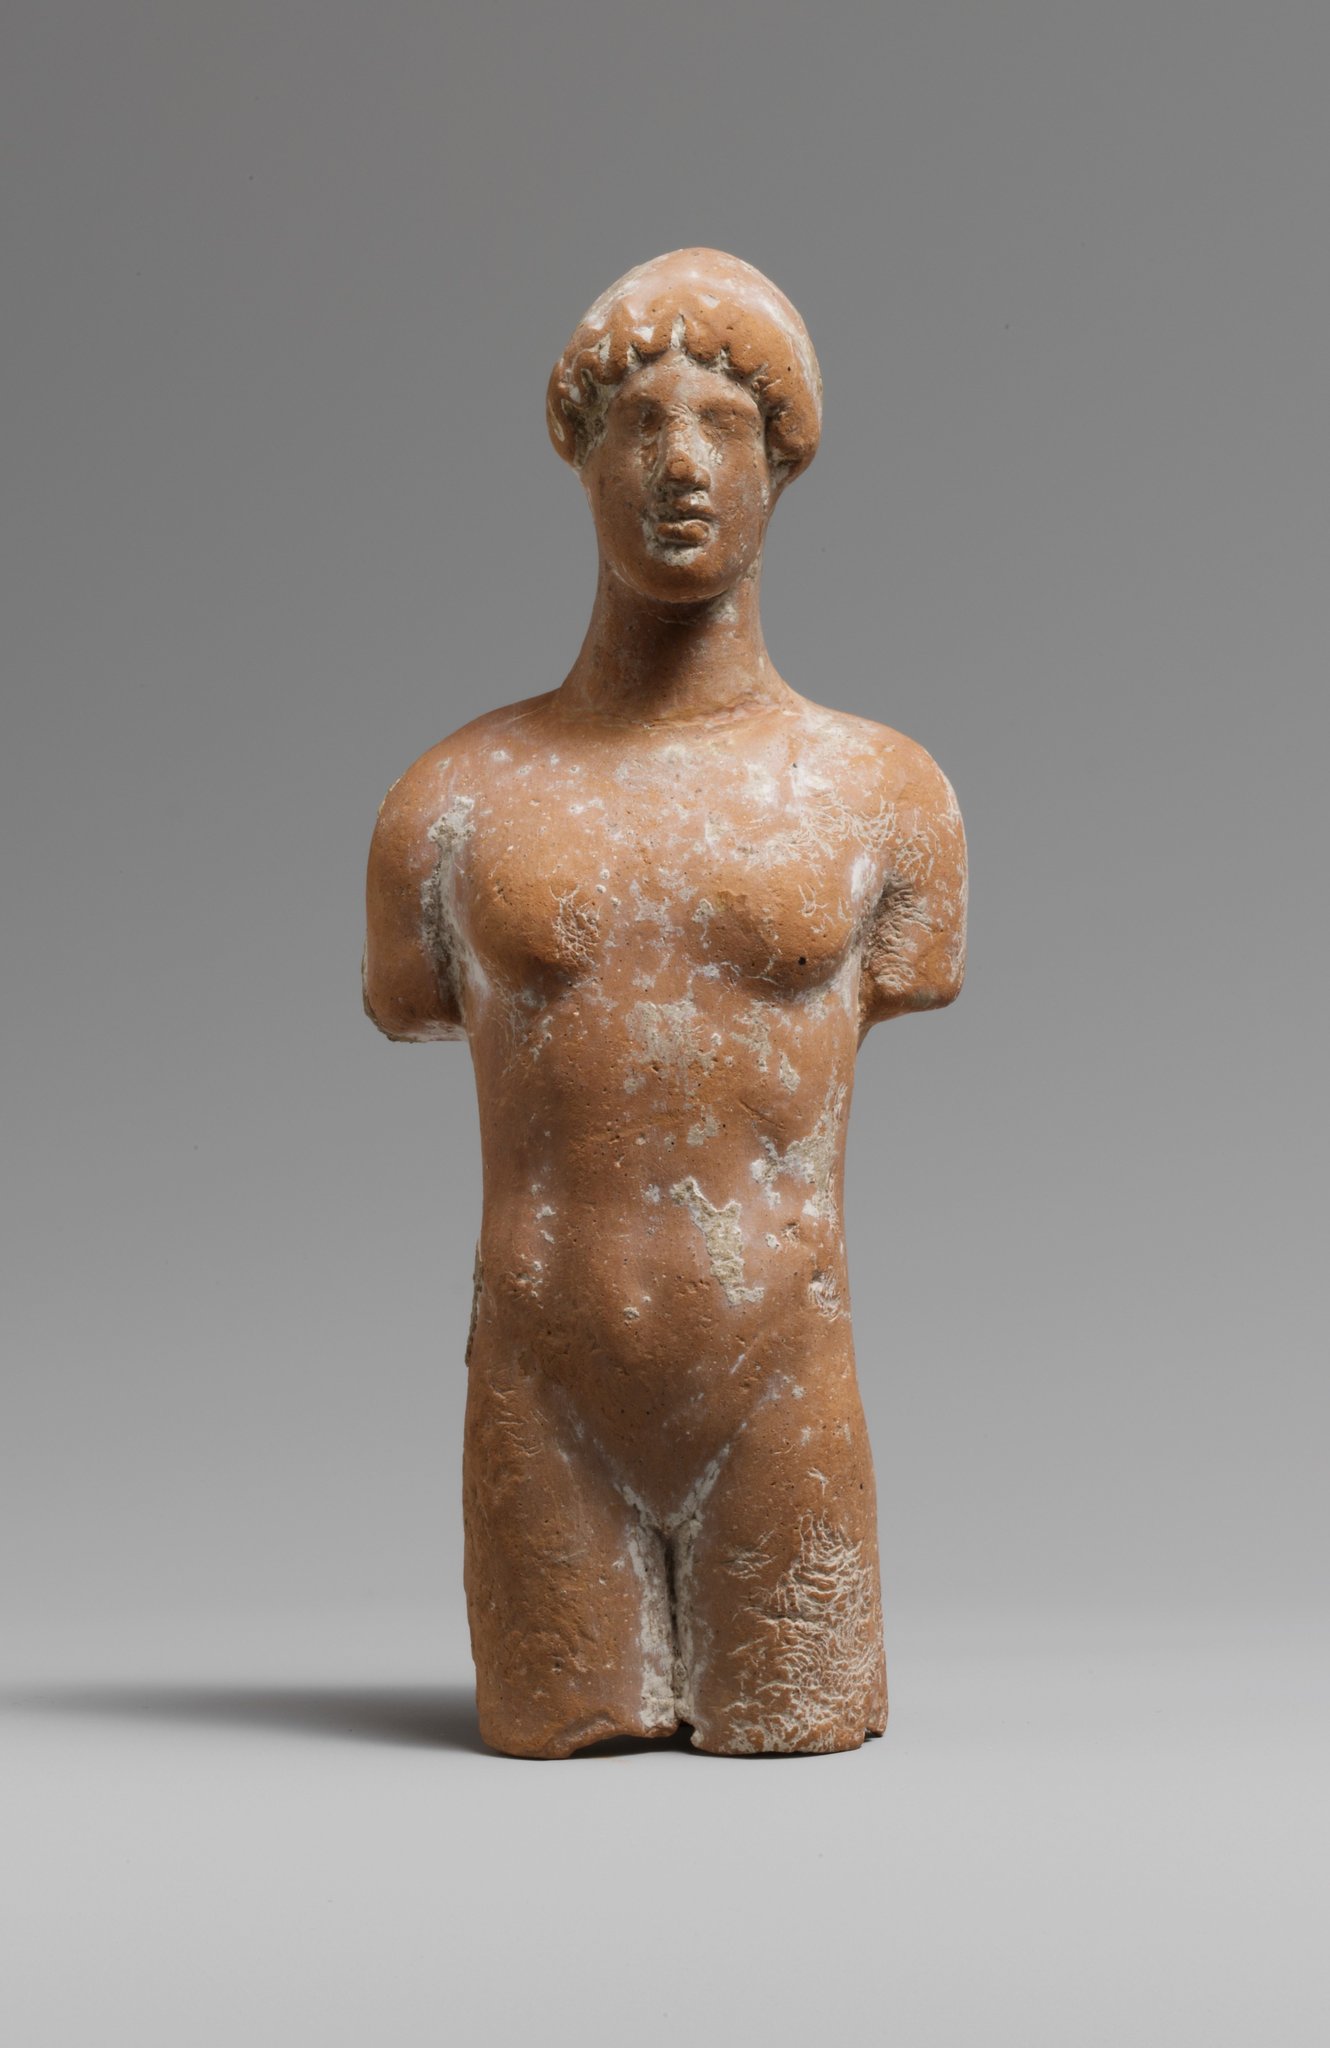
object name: limbless doll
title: Terracotta head and torso of a woman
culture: greek, attic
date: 434-368 BCE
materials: terracotta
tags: women,dolls